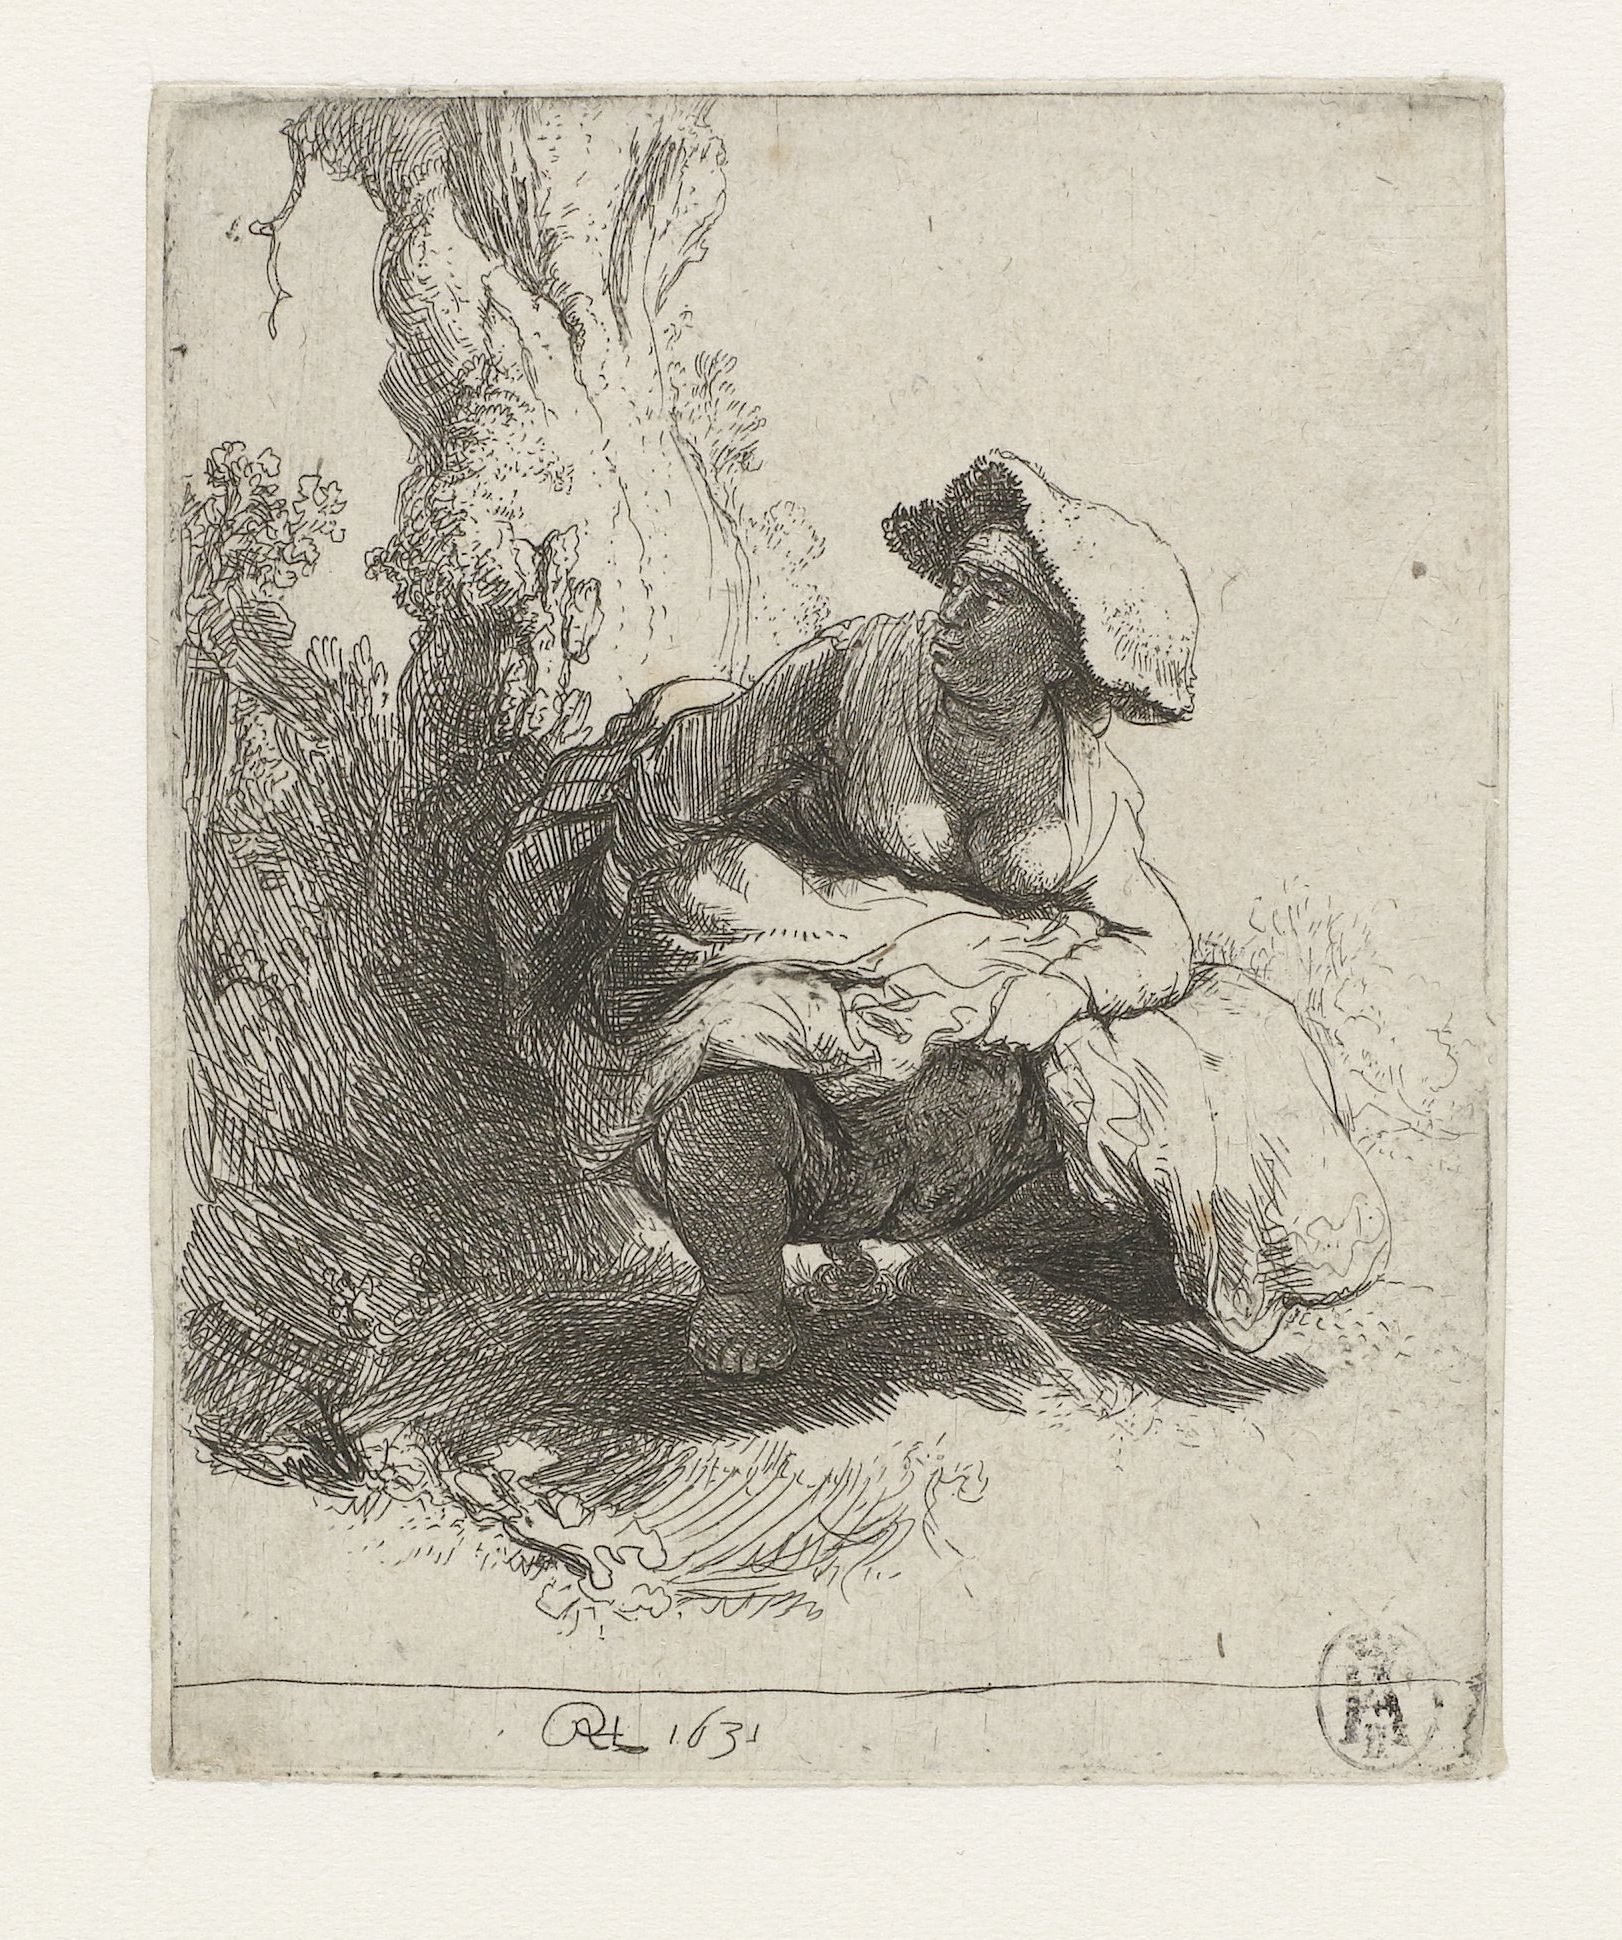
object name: print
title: A Woman Making Water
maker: rembrandt van rijn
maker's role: draughtsman, painter, print maker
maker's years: 1606-1669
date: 1631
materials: paper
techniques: etching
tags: urination, defecation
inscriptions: mark: 972, monogram and date: ‘RHL 1631’ Lugt, mark: Lugt 971, mark: Lugt 2228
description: The man assumes a confident stance and, without taking off his knapsack, produces a powerful stream. The woman does her business behind a tree and keeps a lookout for anyone who might be watching. Nowadays we deem these kinds of scenes as vulgar and inappropriate, but in Rembrandt’s day they were a popular source of amusement.